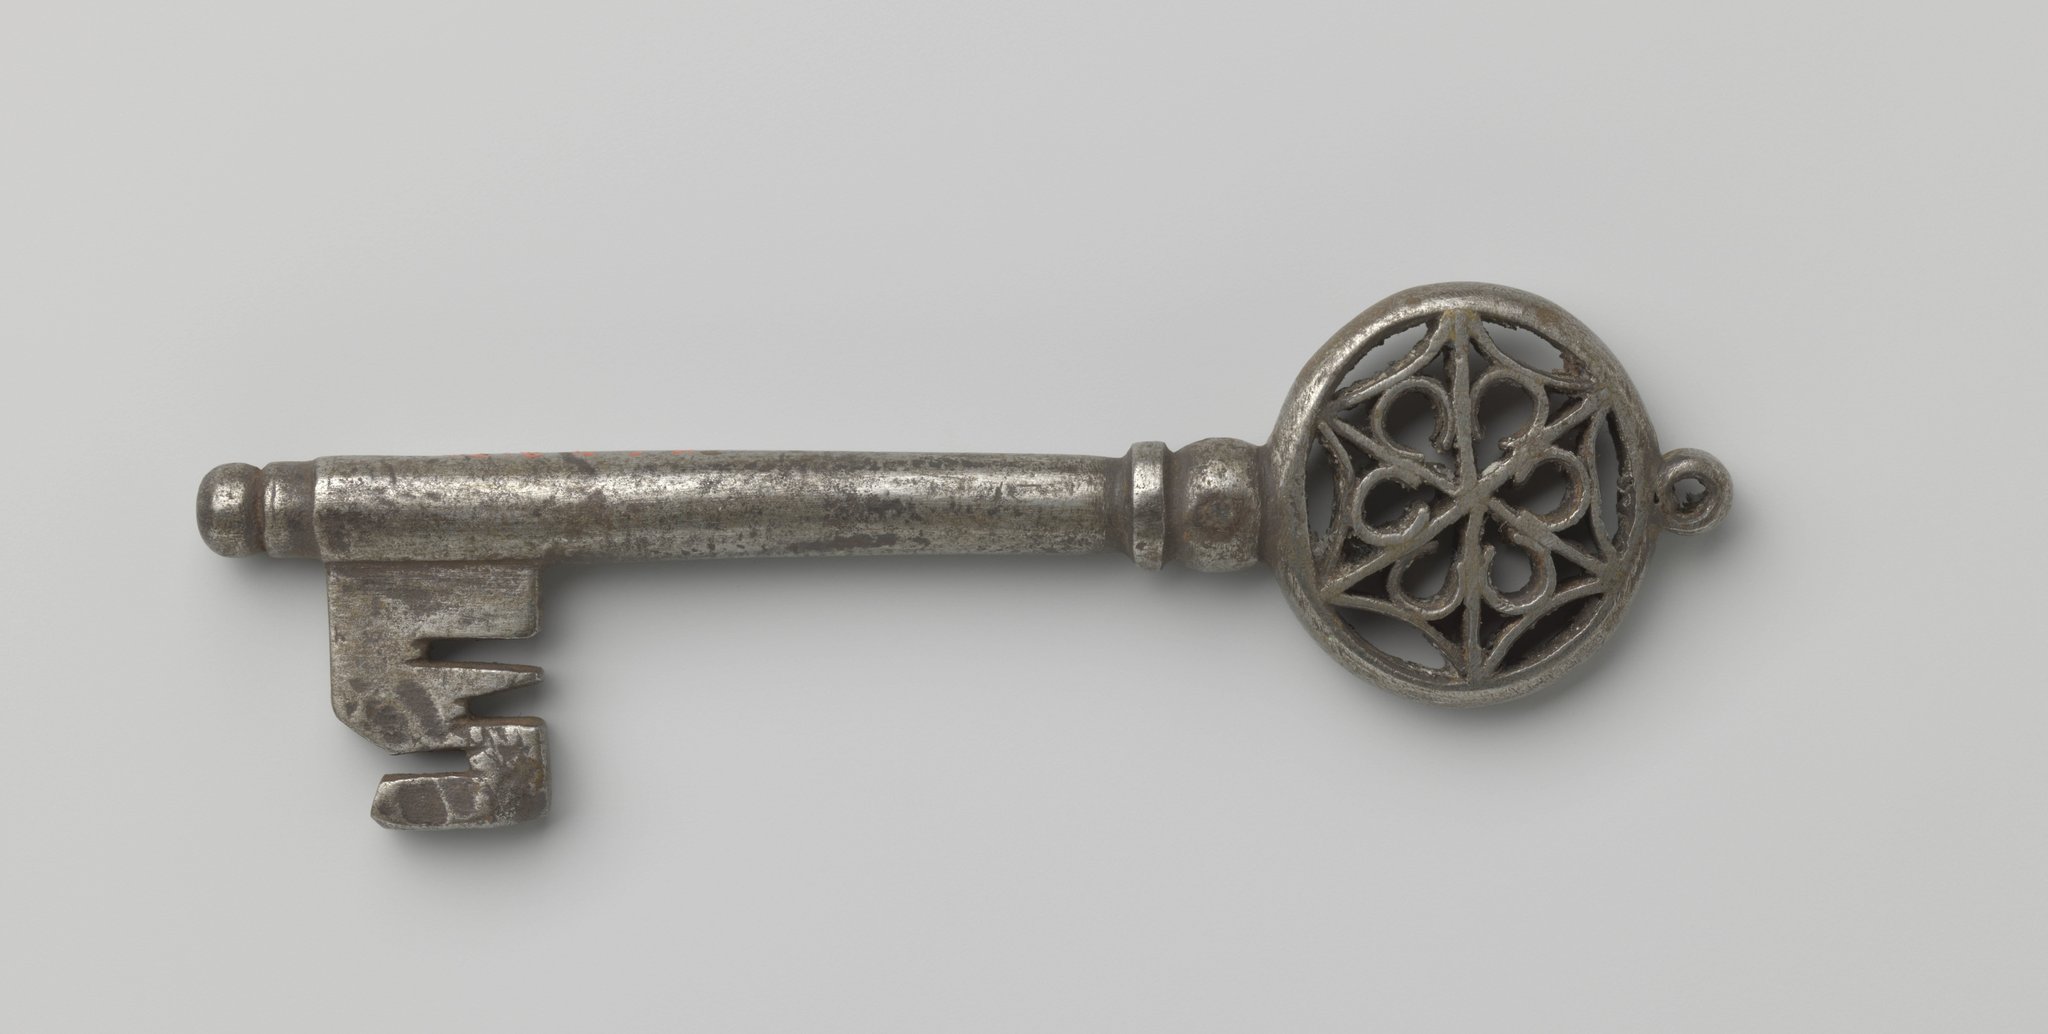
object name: key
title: Sleutel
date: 1500-1600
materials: iron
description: "Venetiaansche sleutel" met roos in de ronde greep., bekroond door een oogje. De schacht voorbij de baard eindigt in een eenvoudige profilering.